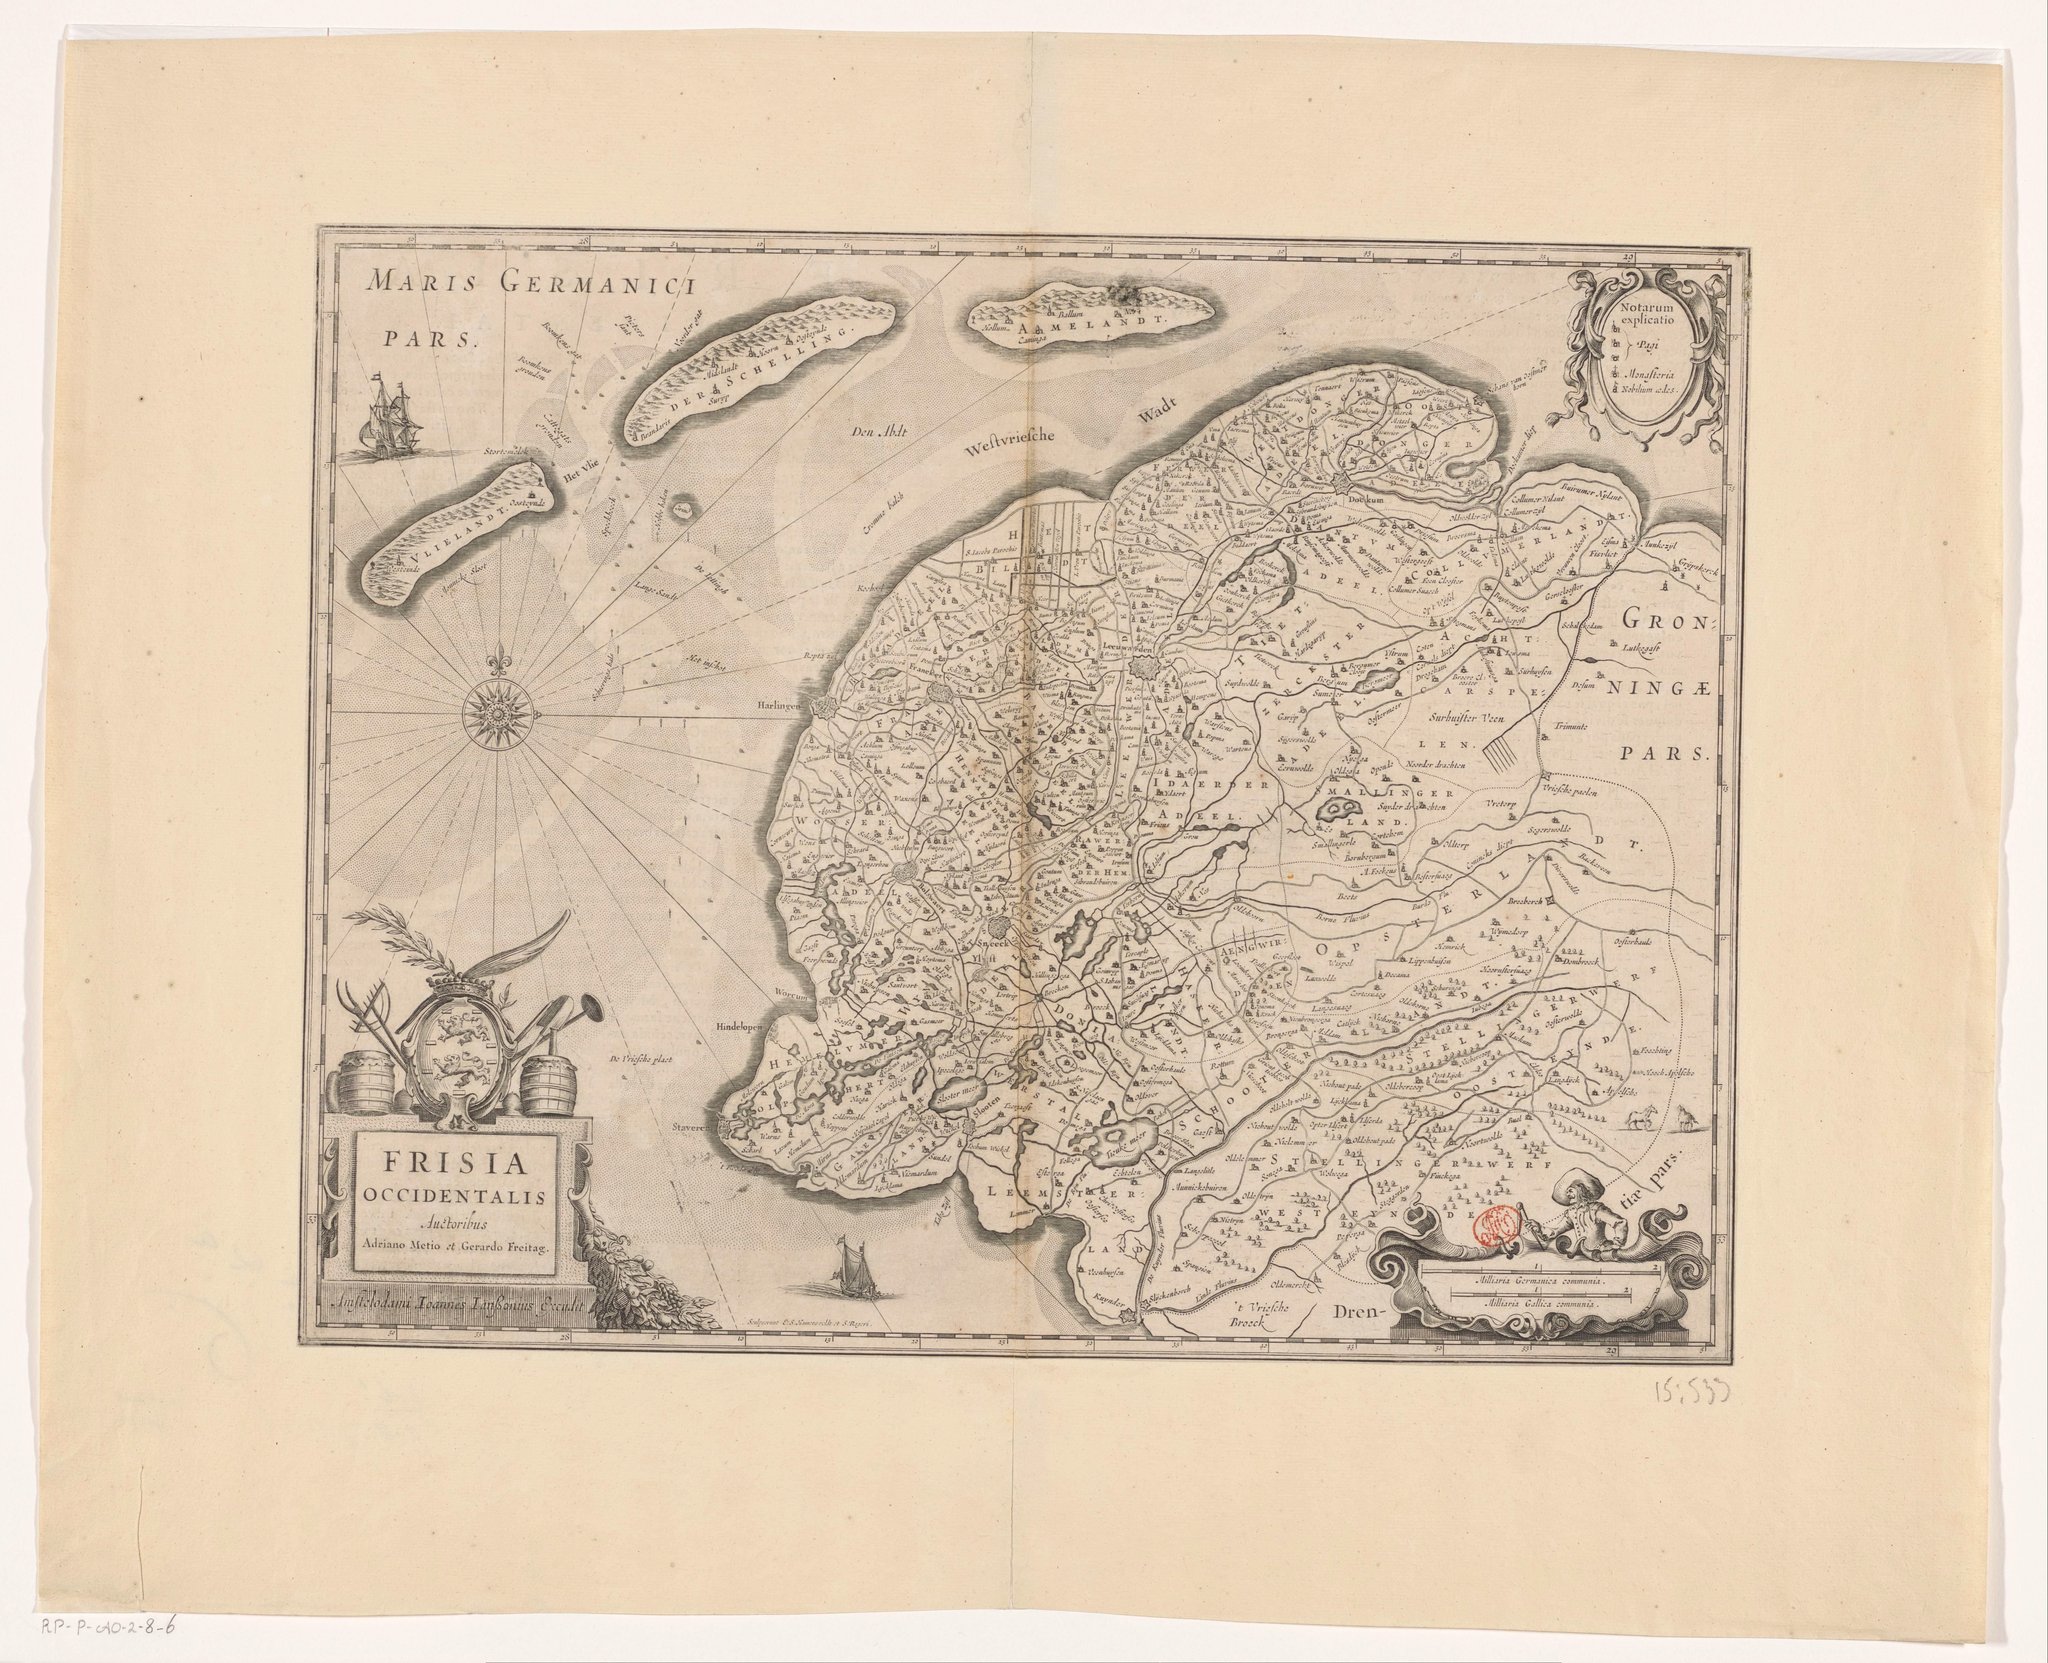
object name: print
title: Kaart van Friesland, Vlieland, Terschelling en Ameland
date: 1630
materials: paper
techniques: engraving, letterpress printing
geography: amsterdam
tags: coat of arms (as symbol of the state, etc.), maps of separate countries or regions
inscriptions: collector's mark: Lugt 2228, collector's mark: Lugt 195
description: Linksonder titelcartouche met daarboven het wapen van Friesland. Rechtsboven legenda, rechtsonder twee schaalstokken: Milliaria Germanica communia, Milliaria Gallica communia. Daarboven een manfiguur met een passer. Gradenverdeling langs de randen. Op verso Latijnse tekst.